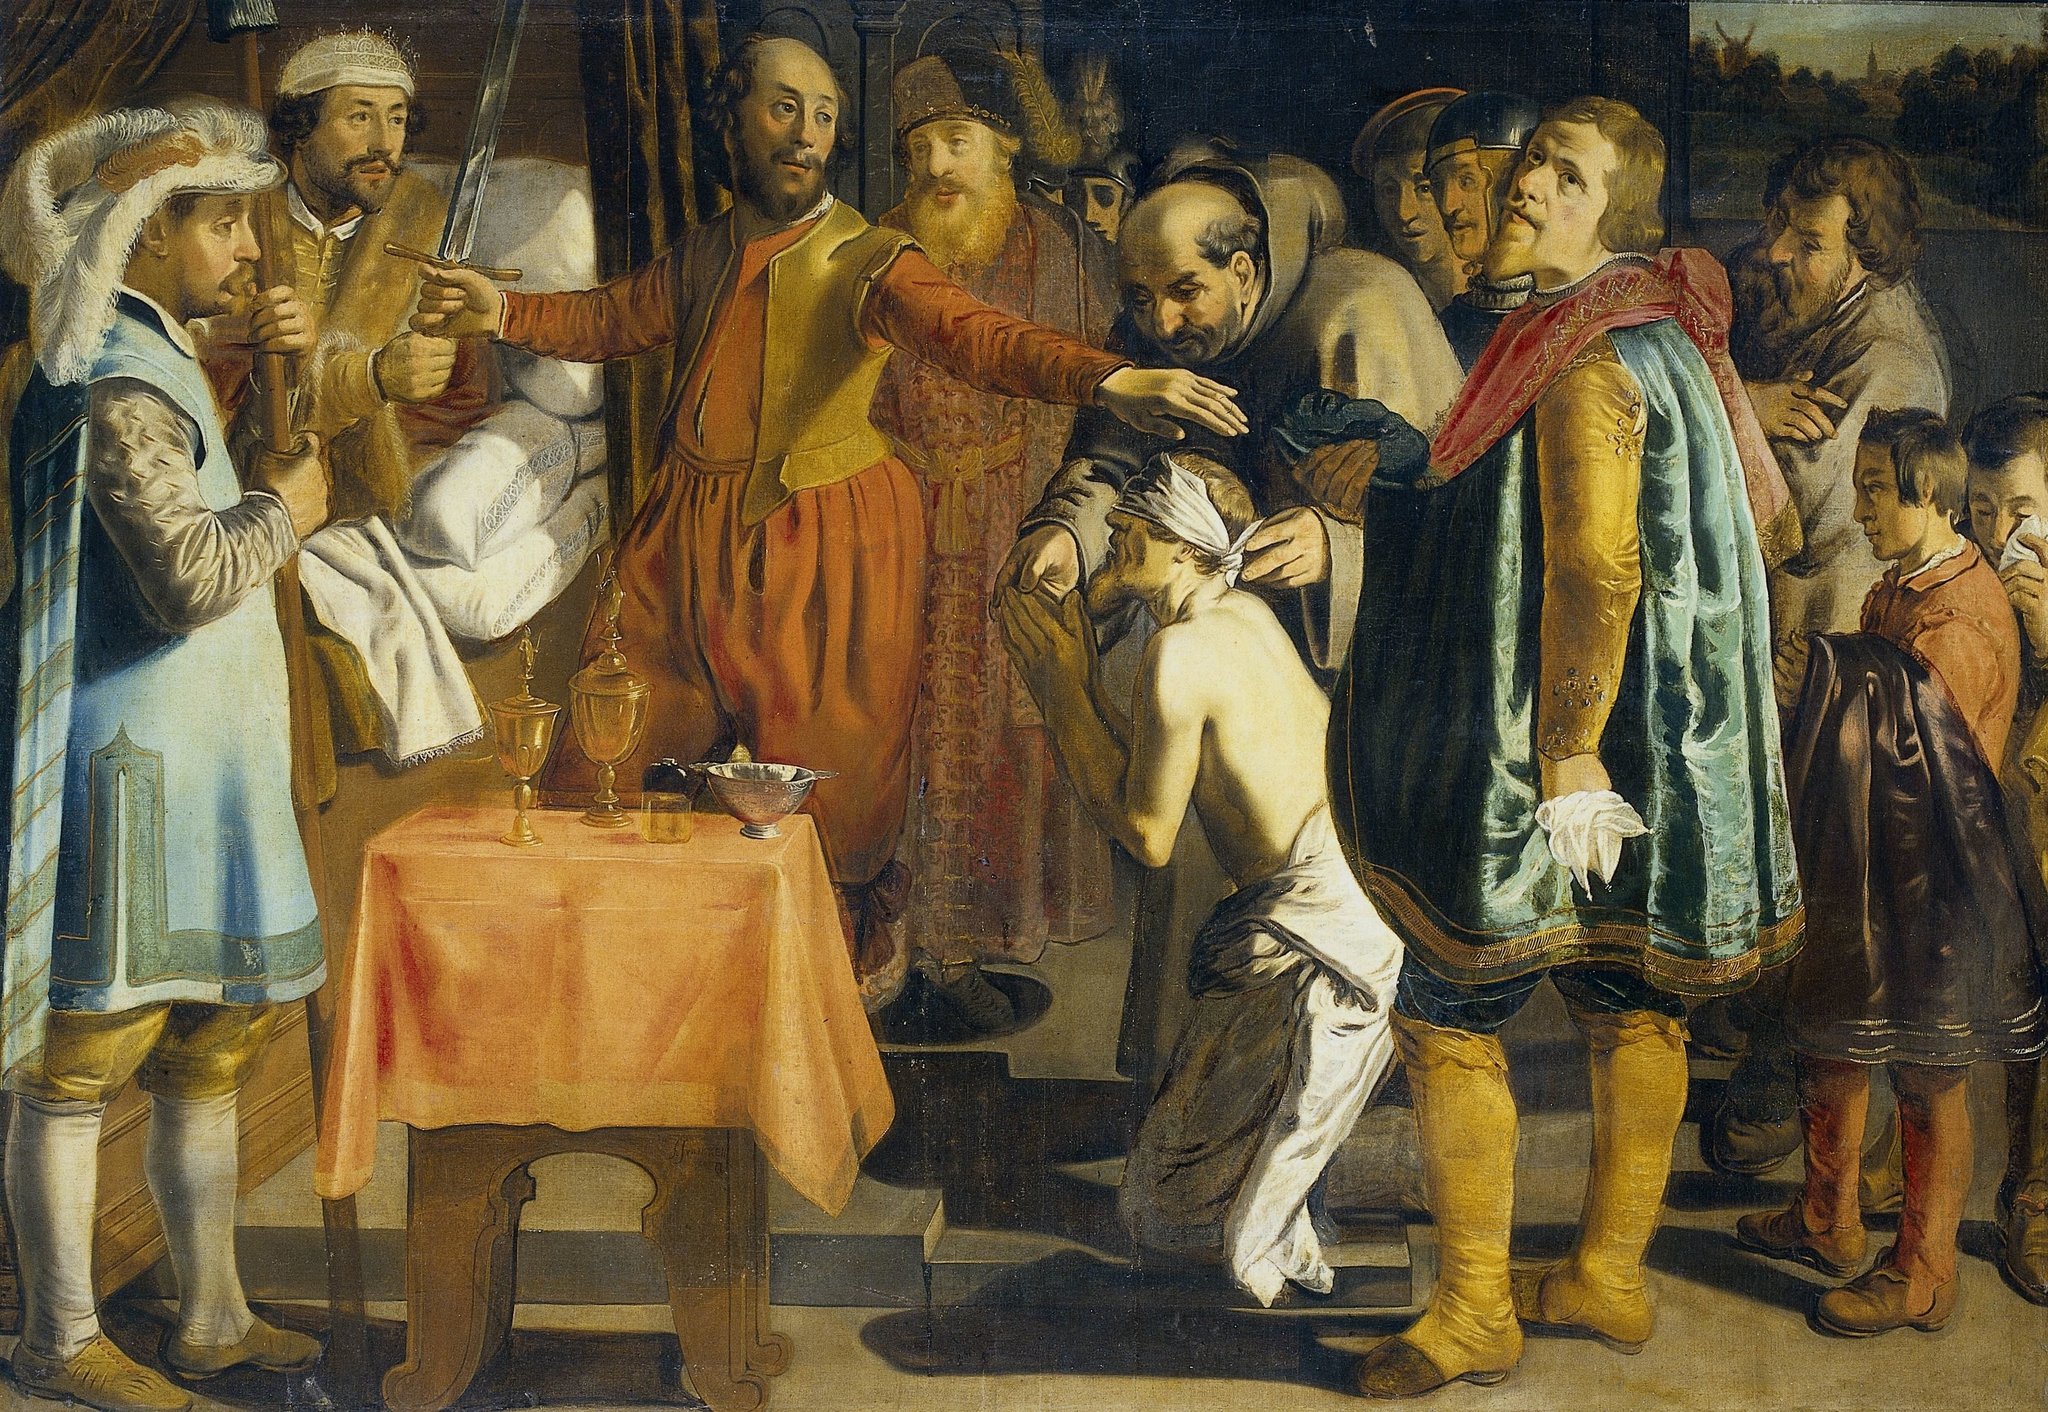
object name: painting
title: Willem III, Count of Holland, Ordering the Beheadal of the Bailiff of Zuid Holland, 1336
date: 1620-1649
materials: canvas, oil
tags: willem iii de goede (graaf van holland en henegouwen), judicial verdict, death penalty, execution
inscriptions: signature (false): ‘F. Francke Aº 1617’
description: Willem III, graaf van Holland, geeft opdracht de baljuw van Zuid-Holland te onthoofden, 1336. De graaf, links ziek te bed, geeft opdracht aan de beul om de baljuw, die geblinddoekt en halfnaakt voor hem knielt, te onthoofden. Een priester ontfermt zich over de veroordeelde.